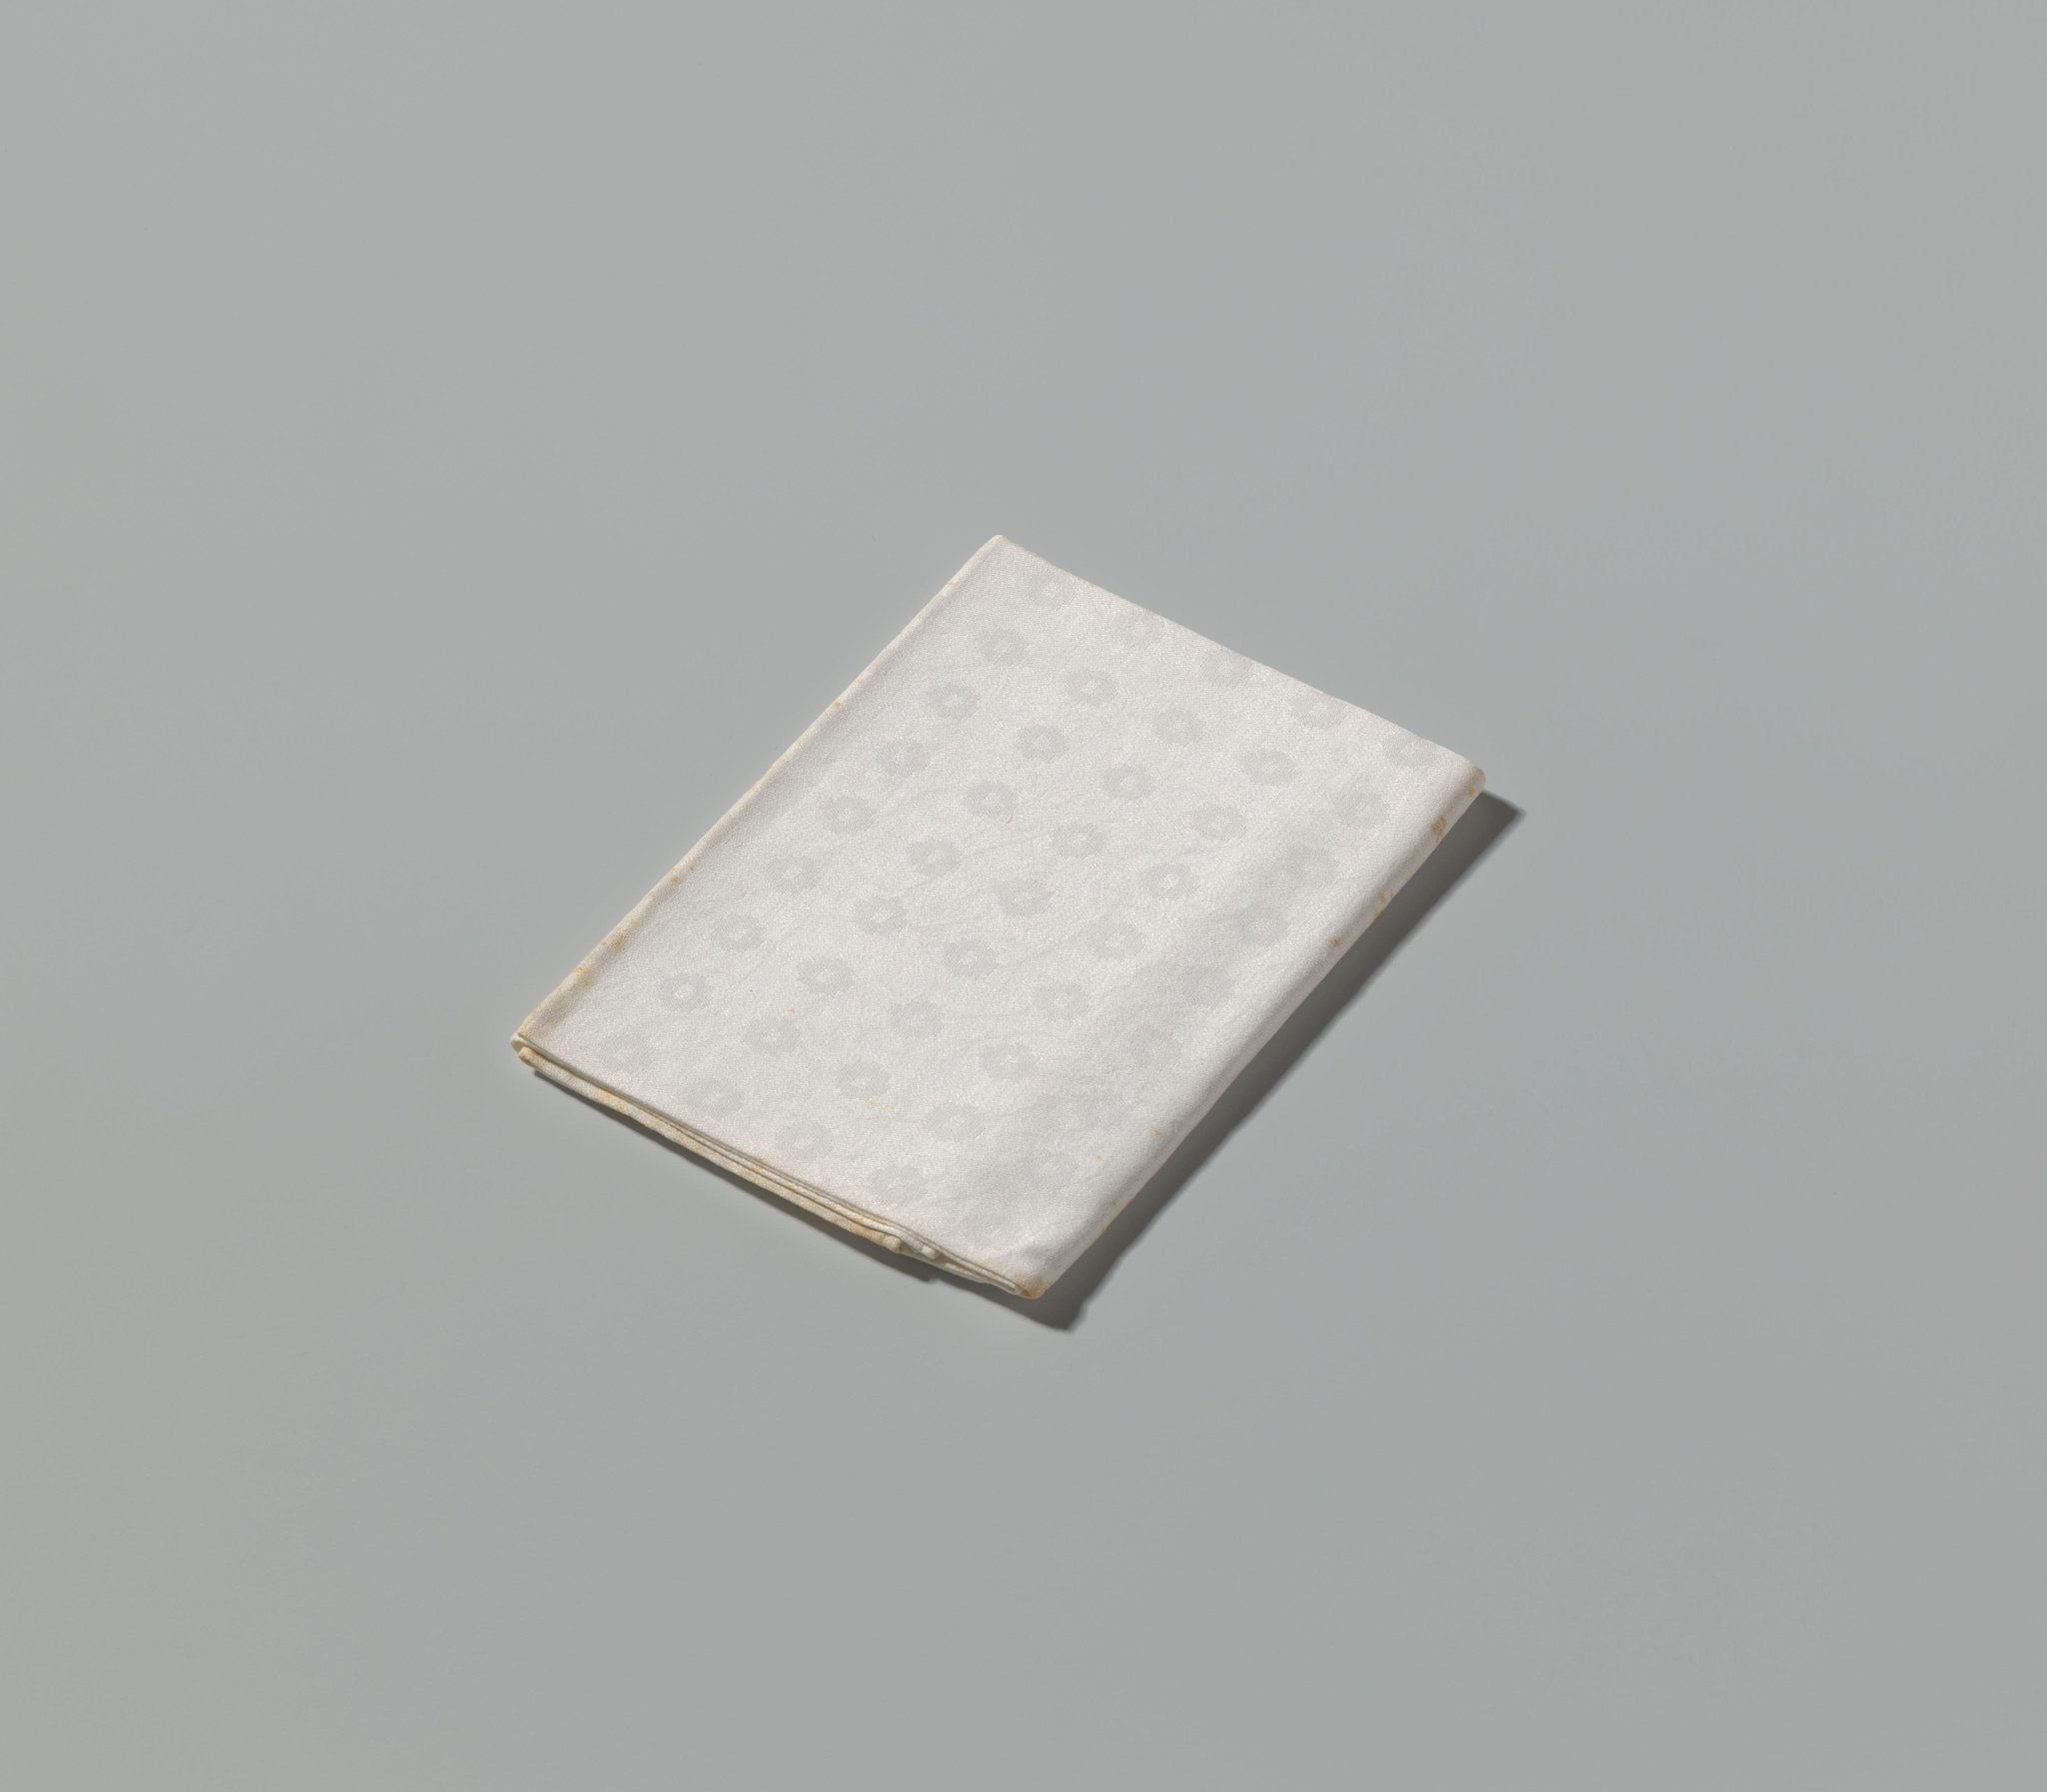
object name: towel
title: Handdoek van pellendamast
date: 1800-1900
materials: linen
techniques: cross stitching, weave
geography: north brabant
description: Handdoek van linnen pellendamast. Het veld heeft rijen rozetten en de rand gestreepte rijen die bestaan uit korte gegolfde lijnen. De handdoek is in rood met een kruissteek gemerkt: SG.